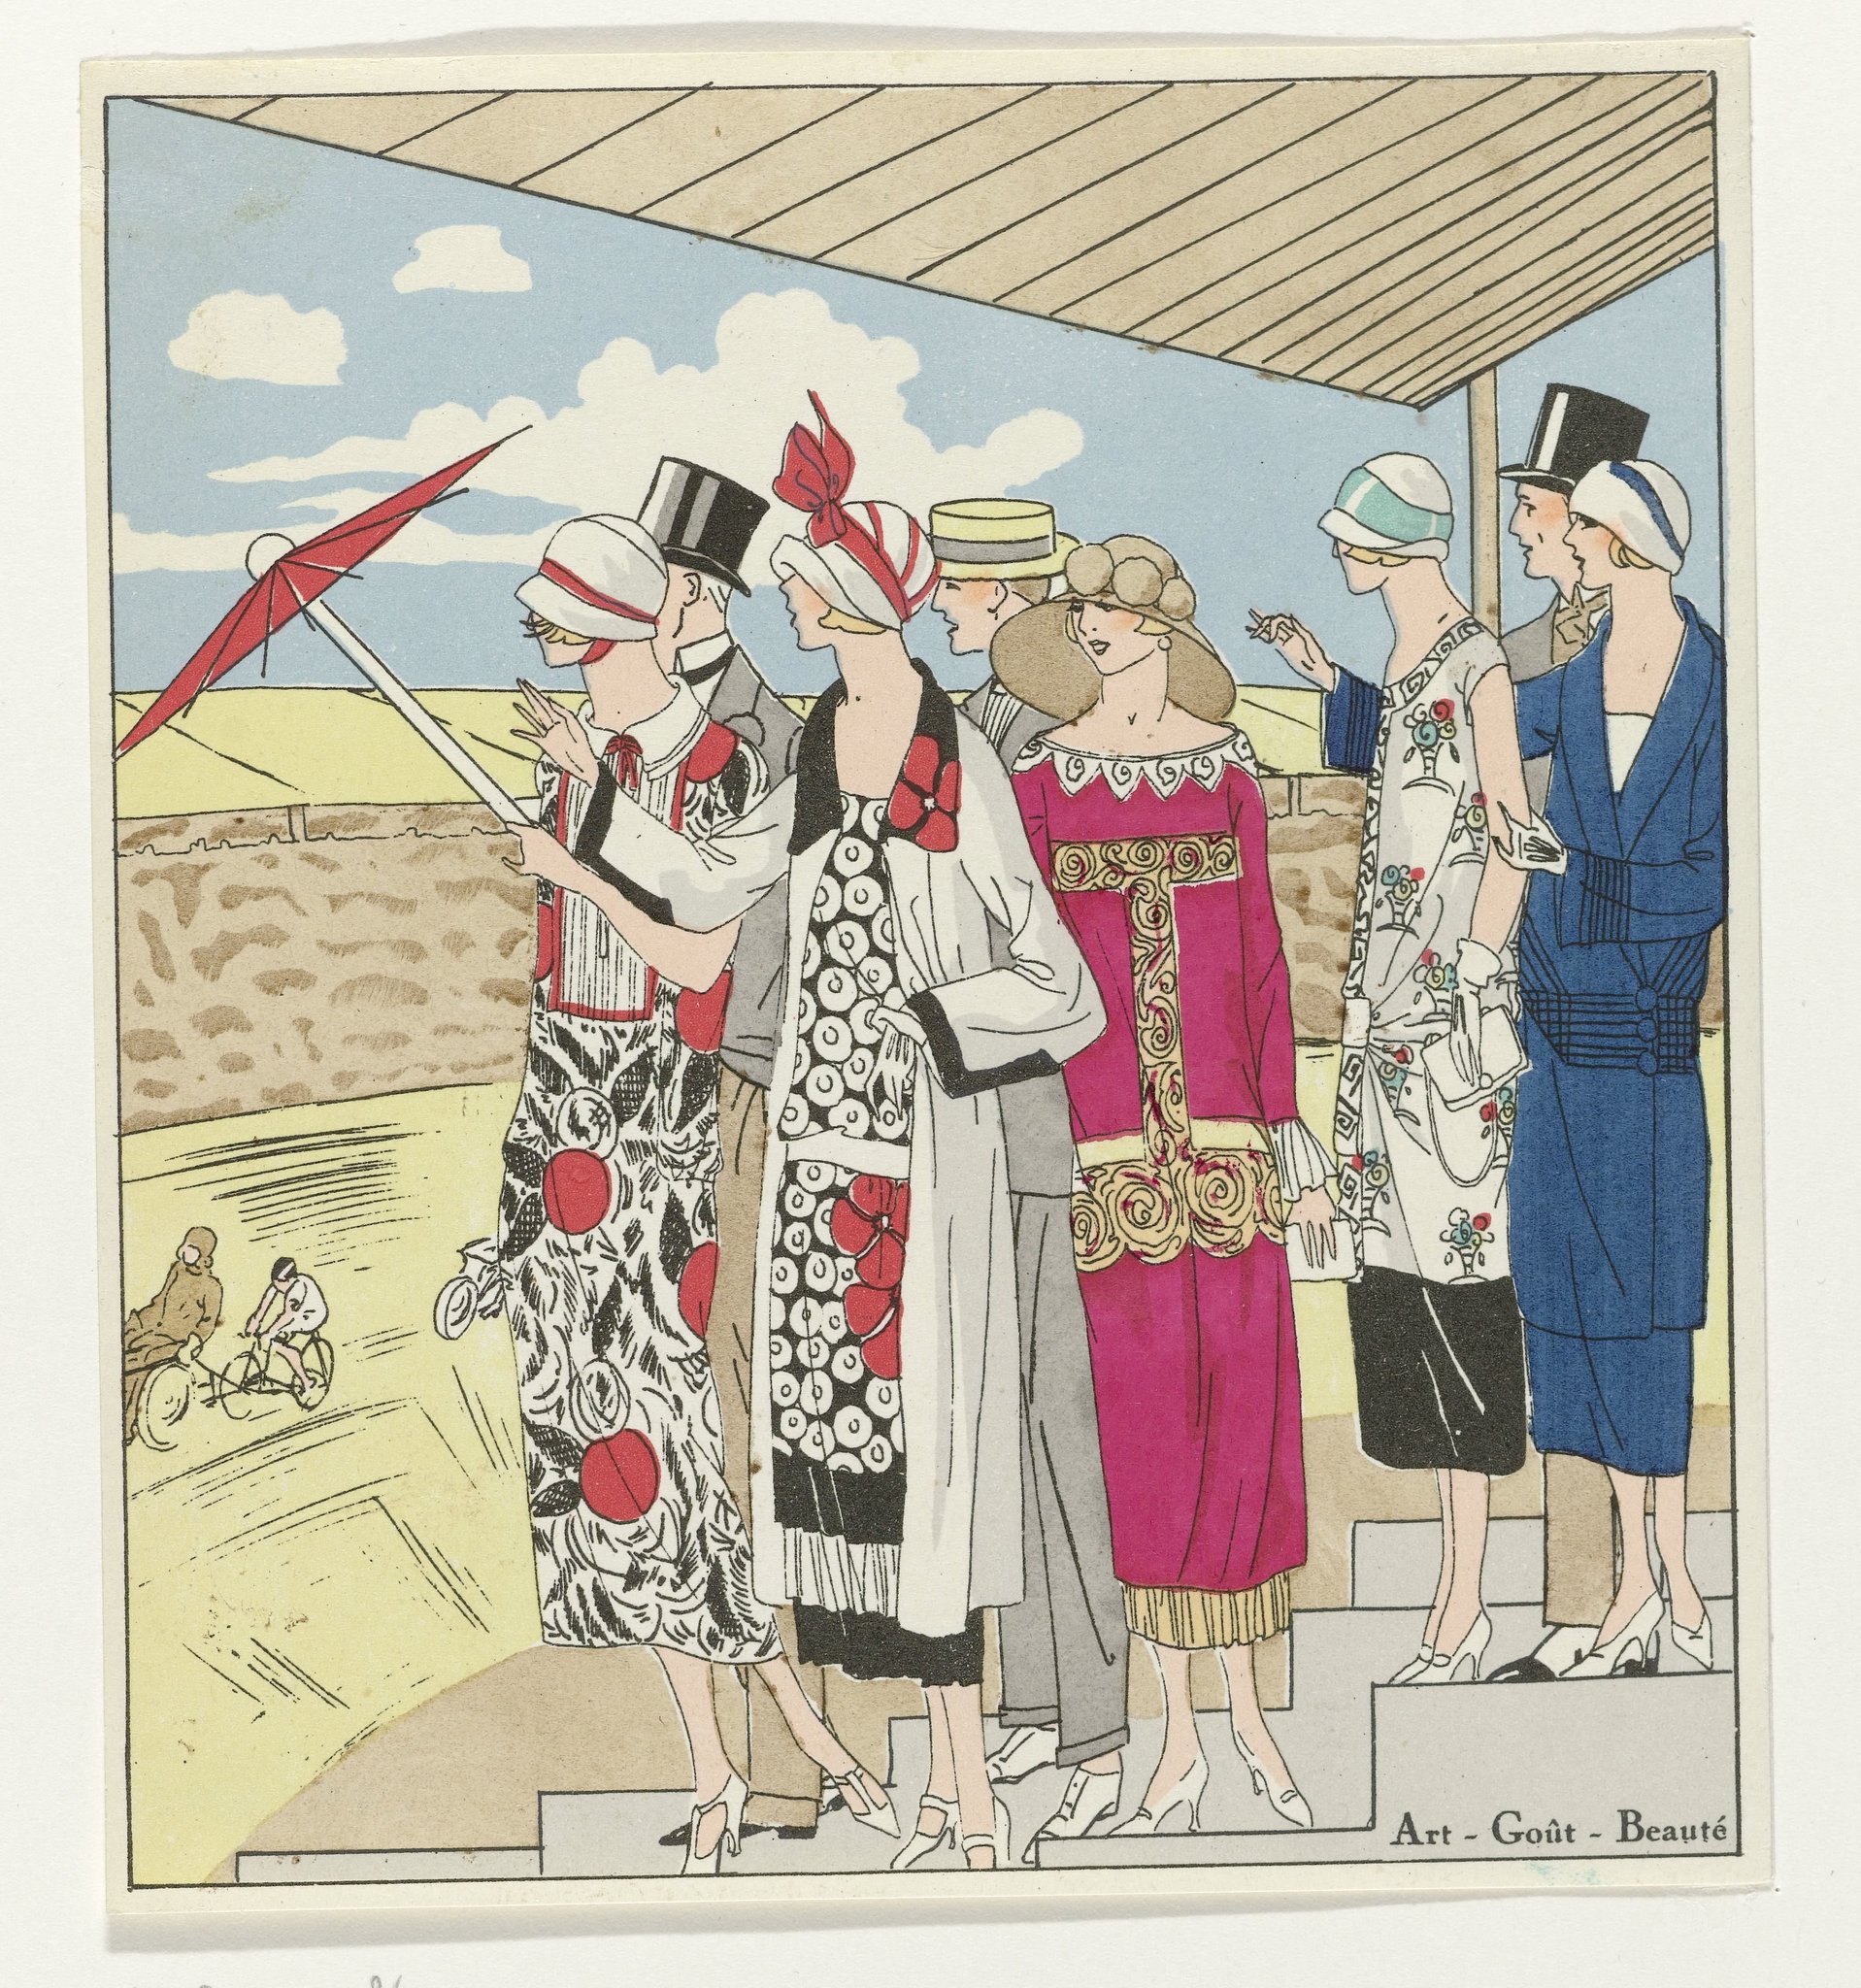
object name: fashion print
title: Art-Goût-Beauté, 1924, No. 6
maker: Anonymous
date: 1924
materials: paper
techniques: engraving, hand coloring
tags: head-gear (+ women's clothes), fashion plates, head-gear: hat (+ women's clothes), dress, gown (+ women's clothes), parasol, sunshade (+ women's clothes)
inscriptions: title: ‘Art-Goût-Beauté’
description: Modieus publiek bij de Olympische spelen Parijs in 1924. De dames zijn gekleed in japonnen met Orientaalse motieven. De twee voorsten van links naar rechts: "Eve" : bedrukte crêpe de chine in rood en zwart (creatie van Philippe et Gaston); "Jongleuse": japon van crêpe de chine bedrukt met een motief van grote rode klaprozen (creatie van Martial et Armand).